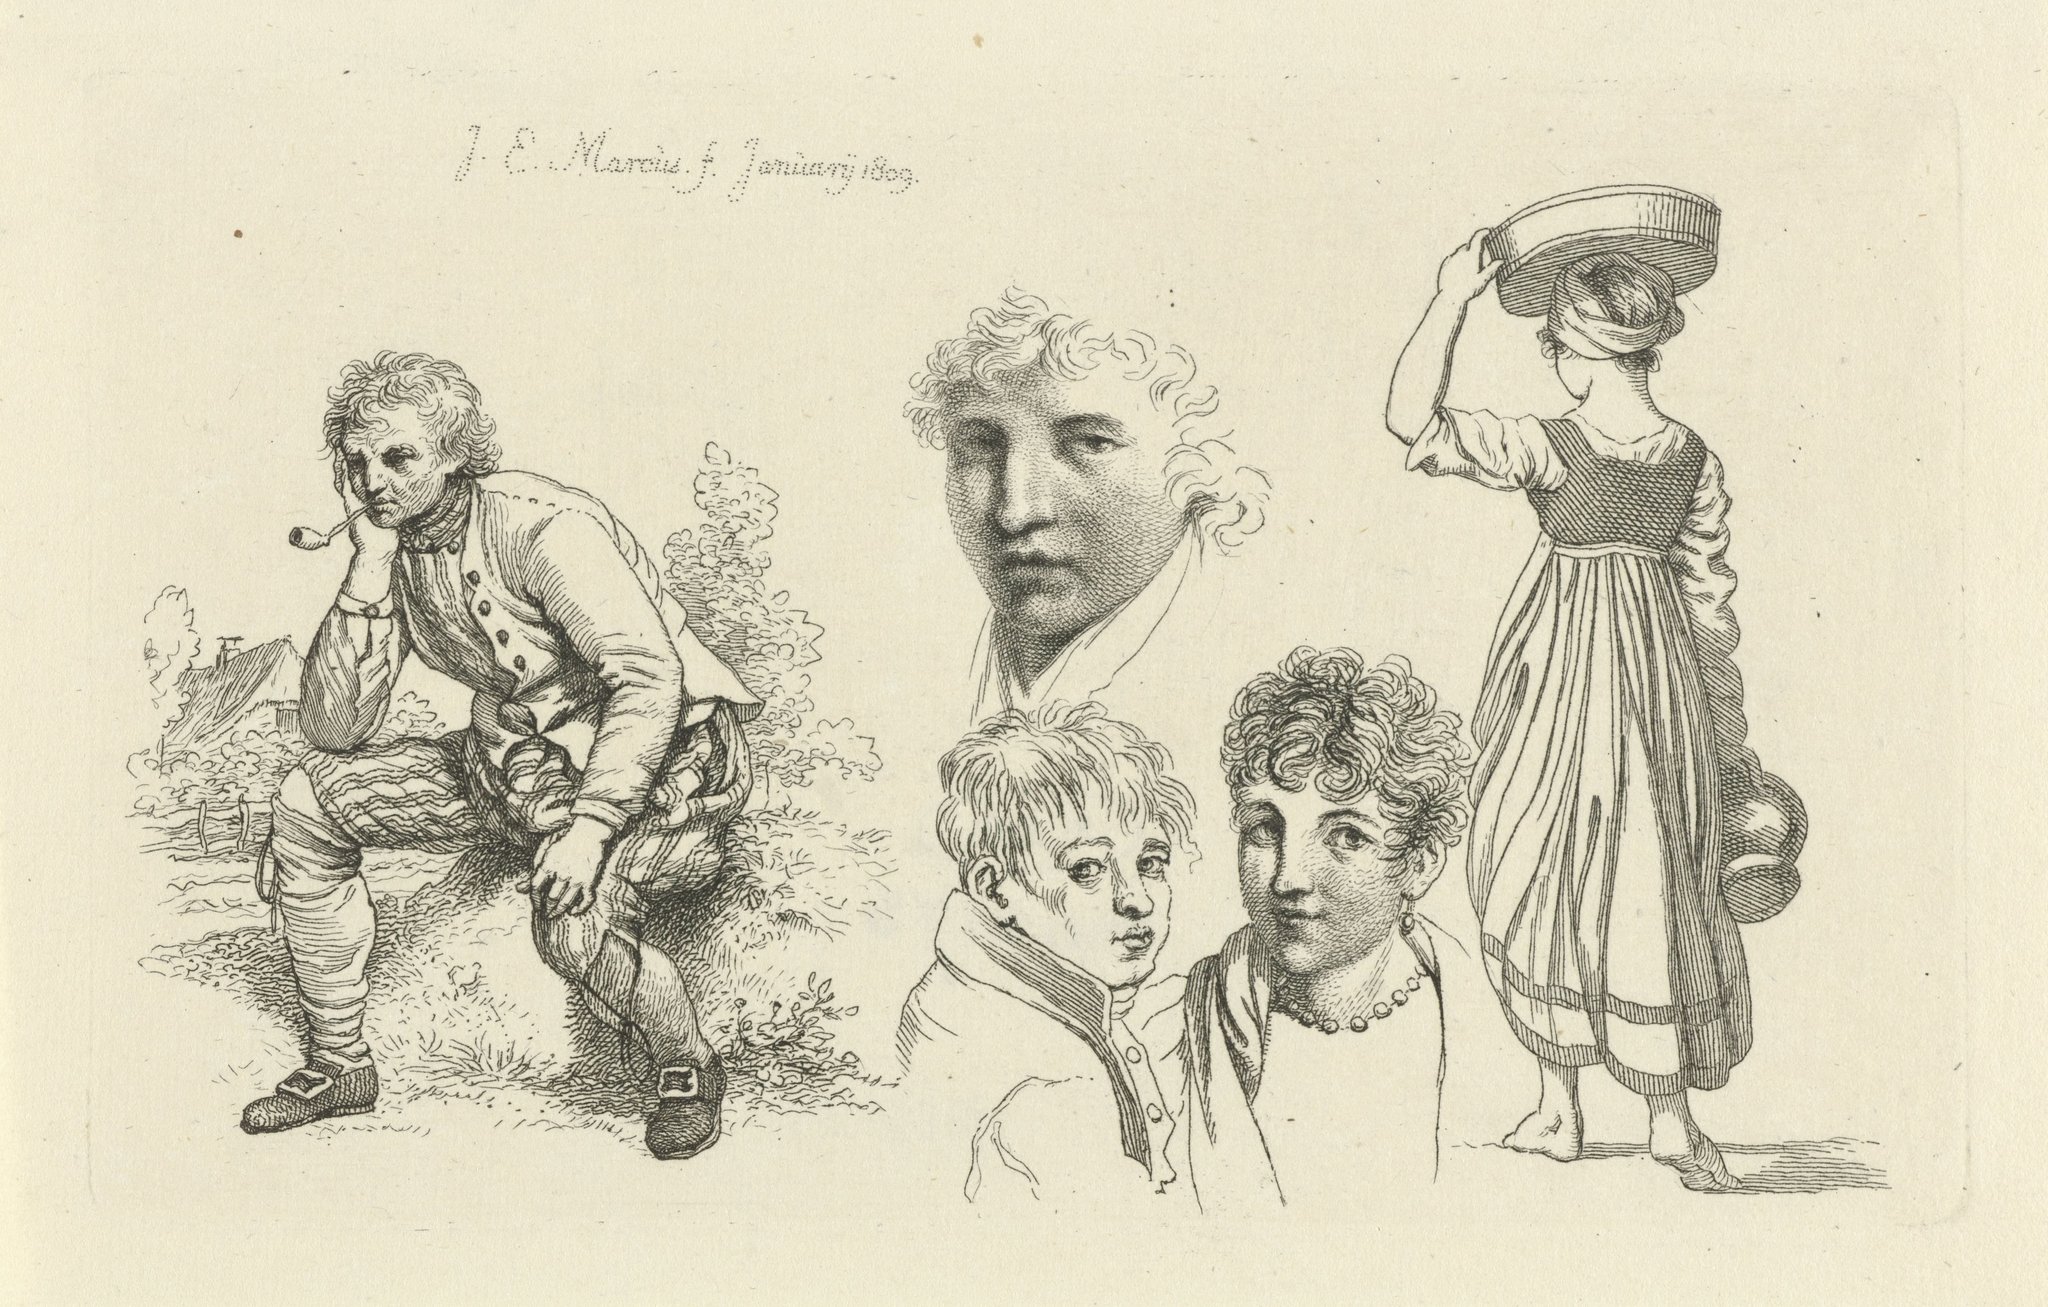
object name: print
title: Studie-prentwerk / Etudes gravées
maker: jacob ernst marcus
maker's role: draughtsman, print maker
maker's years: 1774-1826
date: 1801-1809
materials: paper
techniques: etching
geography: amsterdam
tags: sitting figure, adolescent, young woman, maiden (+ back view), carrying something on the head or on the shoulders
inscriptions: collector's mark: Lugt 2228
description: Serie voor het eerst uitgegeven door Jacob Ernst Marcus onder de titel Studiebeelden en Fragmenten. Amsterdam: ca.1816. Later heruitgegeven als: Studie-prentwerk/ Etudes gravées.